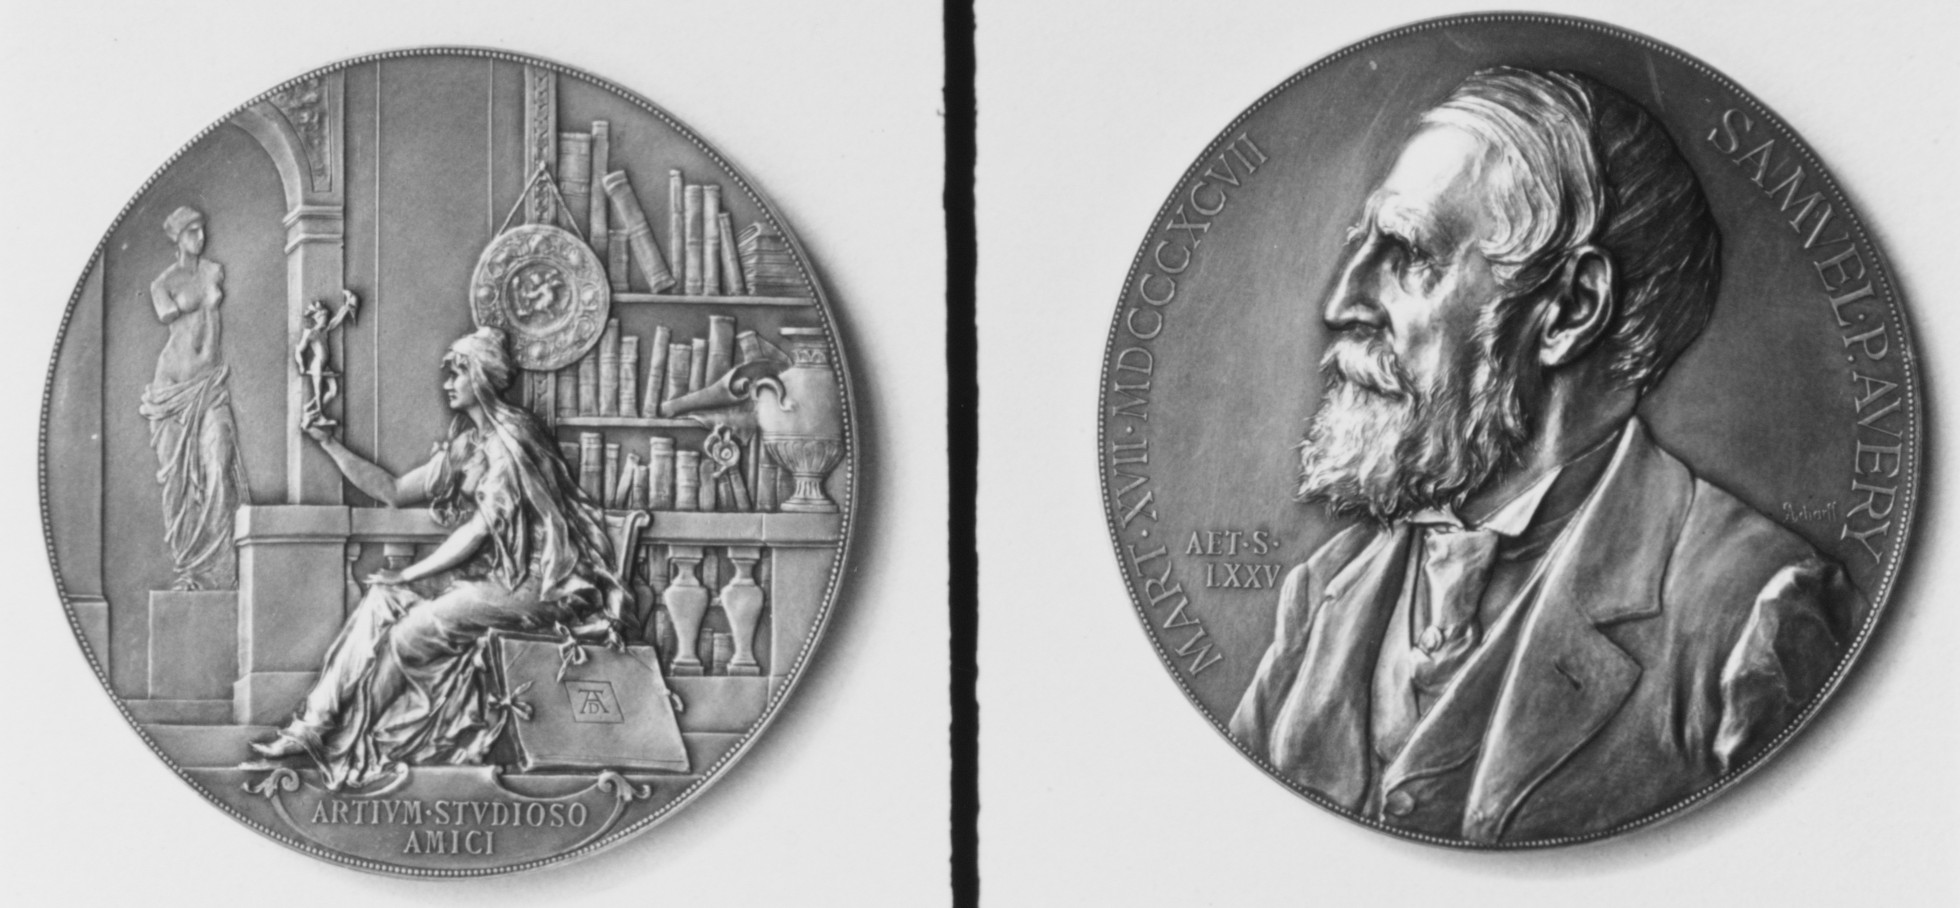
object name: medal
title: Samuel P. Avery (1822–1904): Commemorating His Seventy-Fifth Birthday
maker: anton scharff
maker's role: artist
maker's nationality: austrian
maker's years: 1845-1903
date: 1897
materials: silver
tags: men,profiles,women